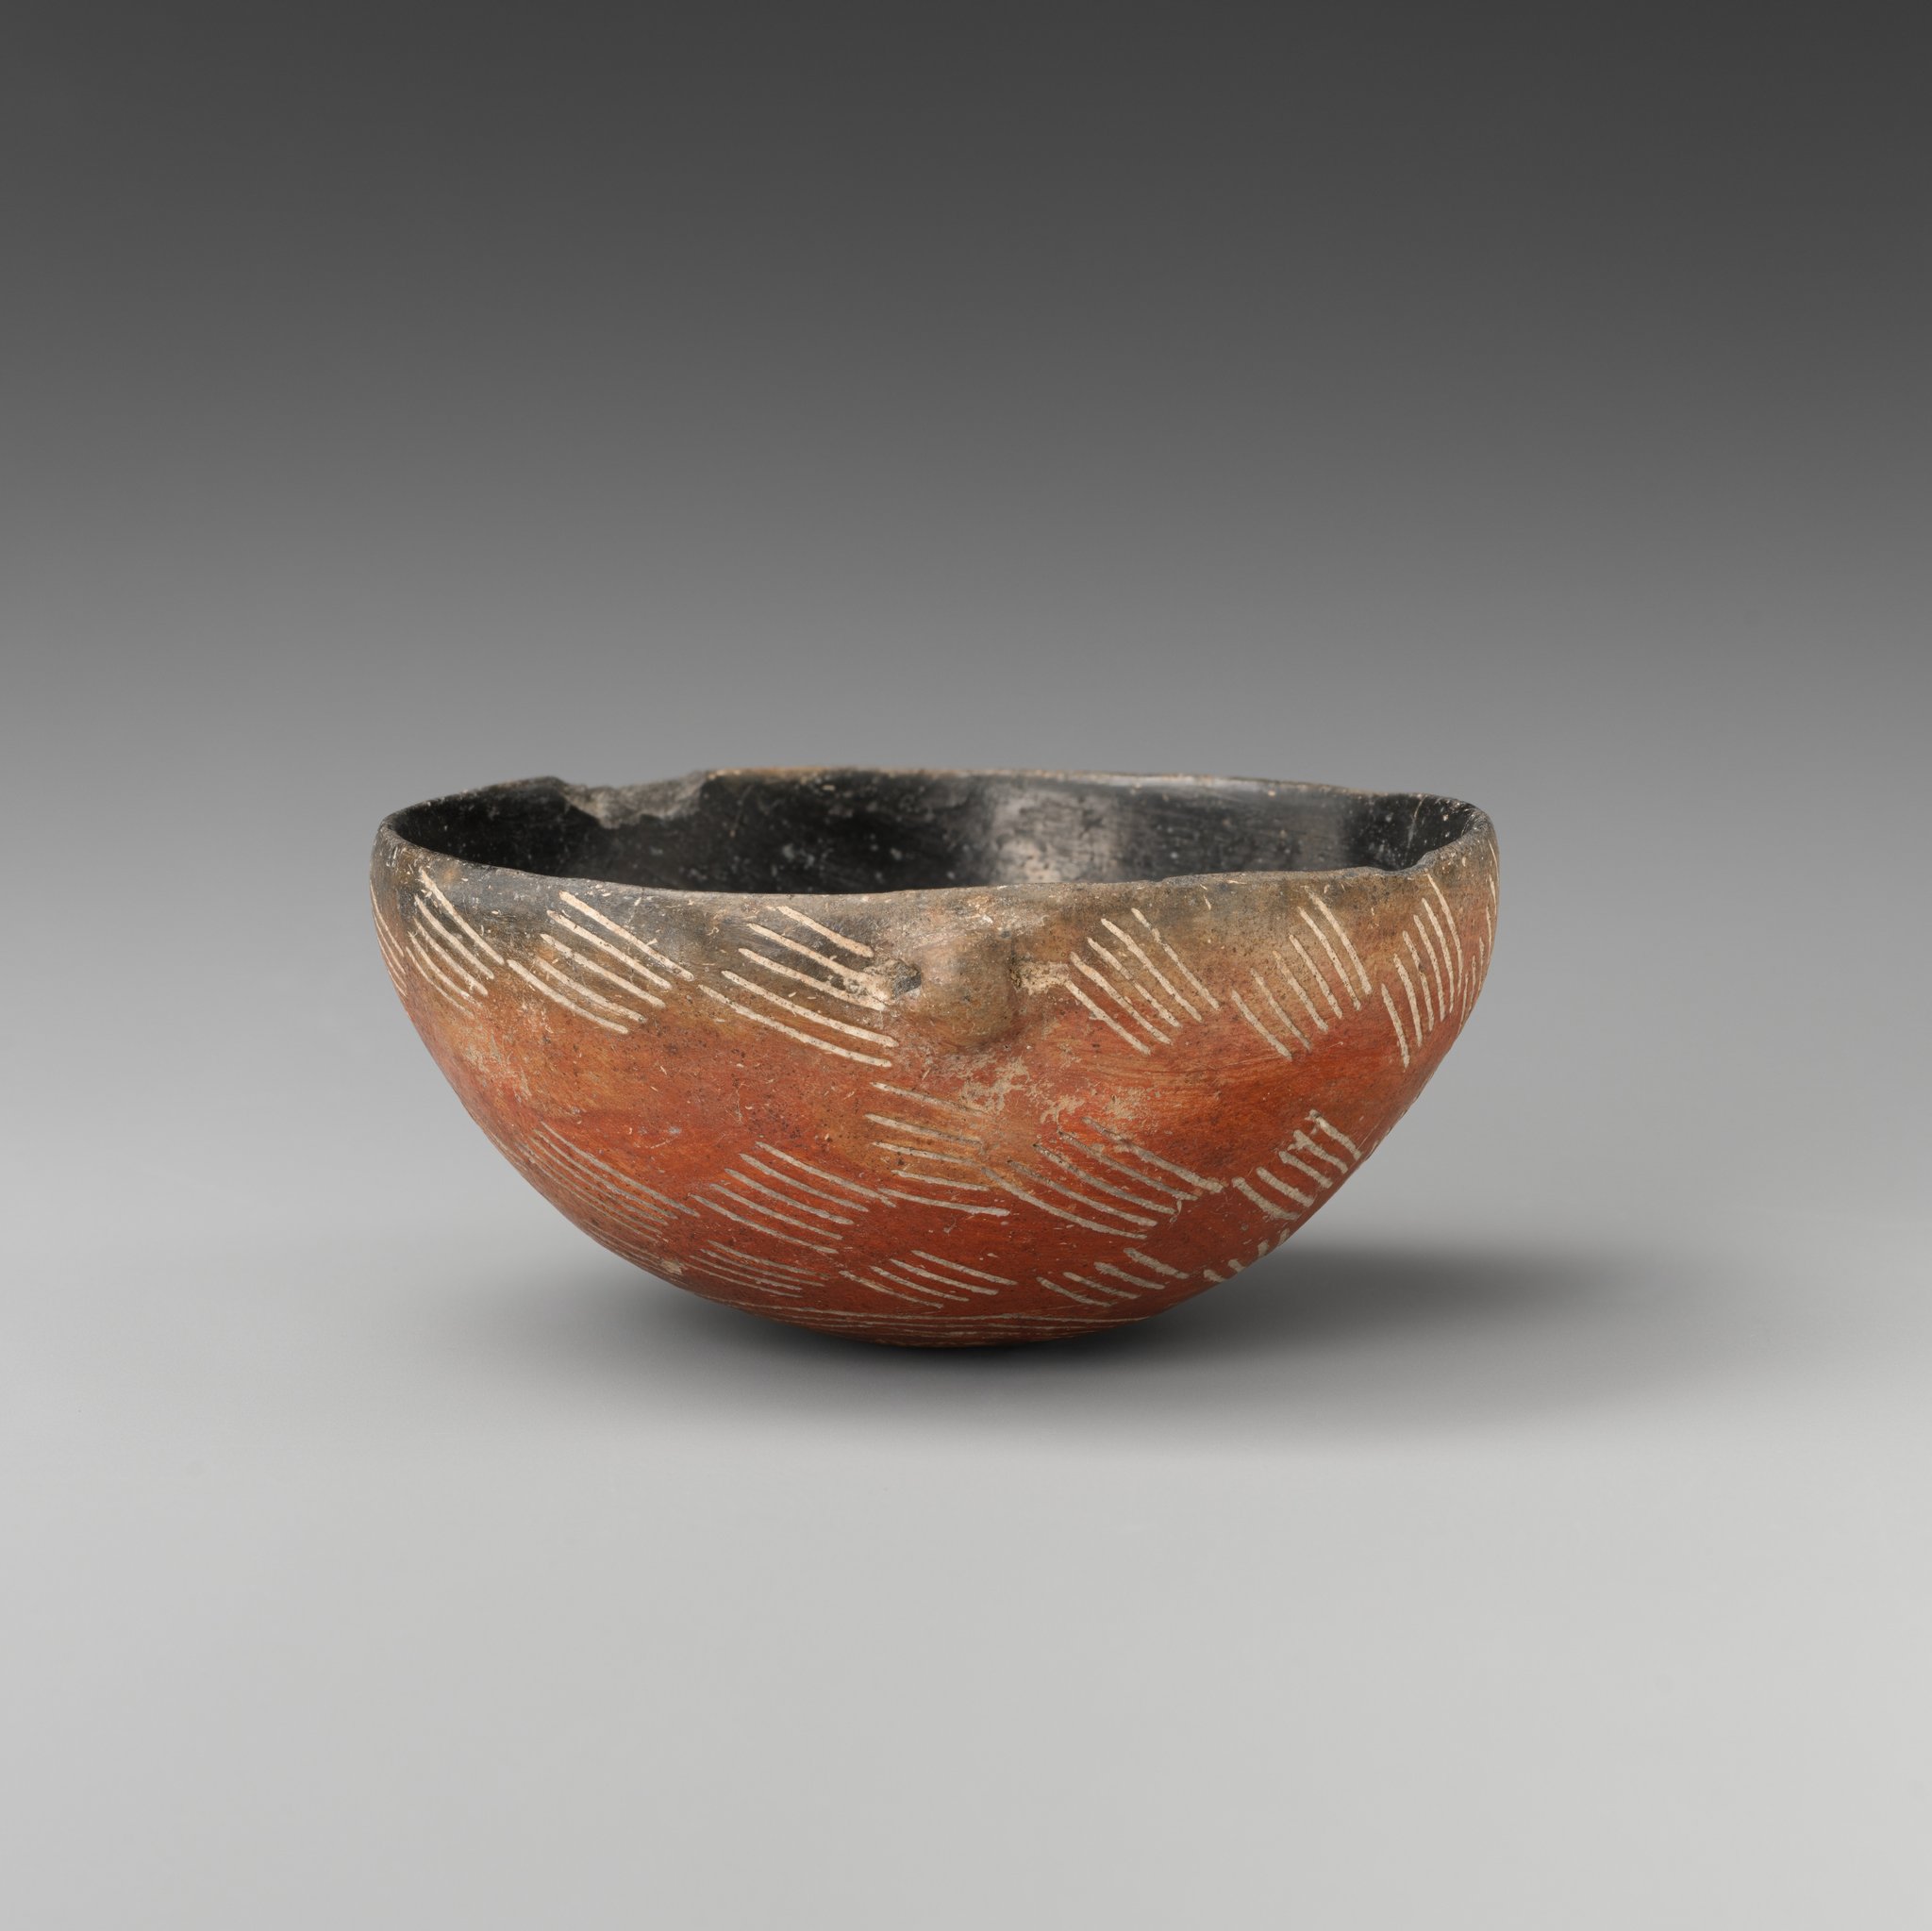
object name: bowl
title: Terracotta bowl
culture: cypriot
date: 2000-1900 BCE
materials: terracotta